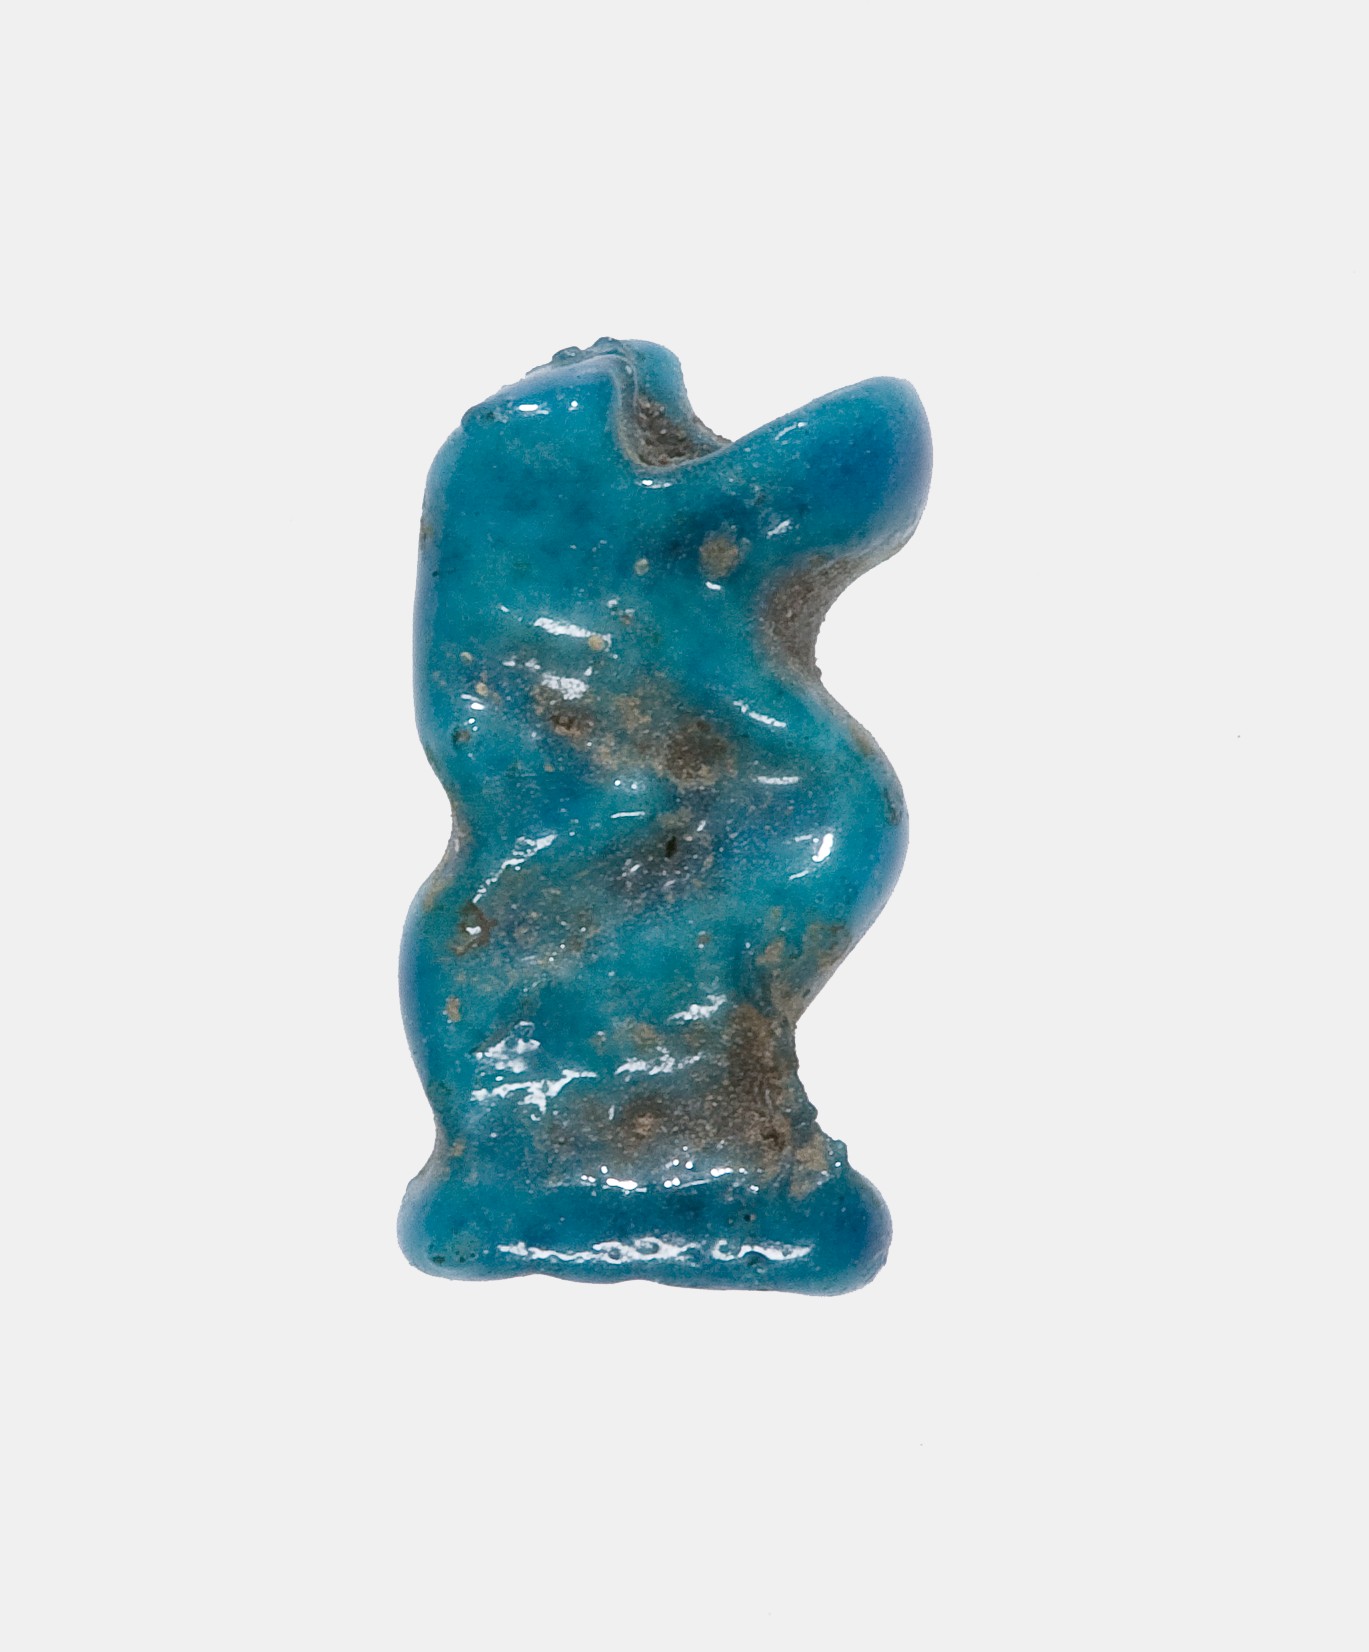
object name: amulet, baboon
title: Baboon Amulet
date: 1802-1450 BCE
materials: faience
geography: egypt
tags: baboons